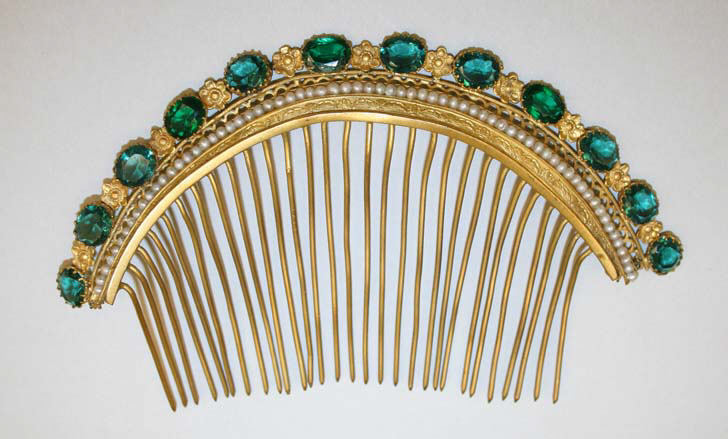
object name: comb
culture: european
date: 1880-1889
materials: metal, pearl, stone